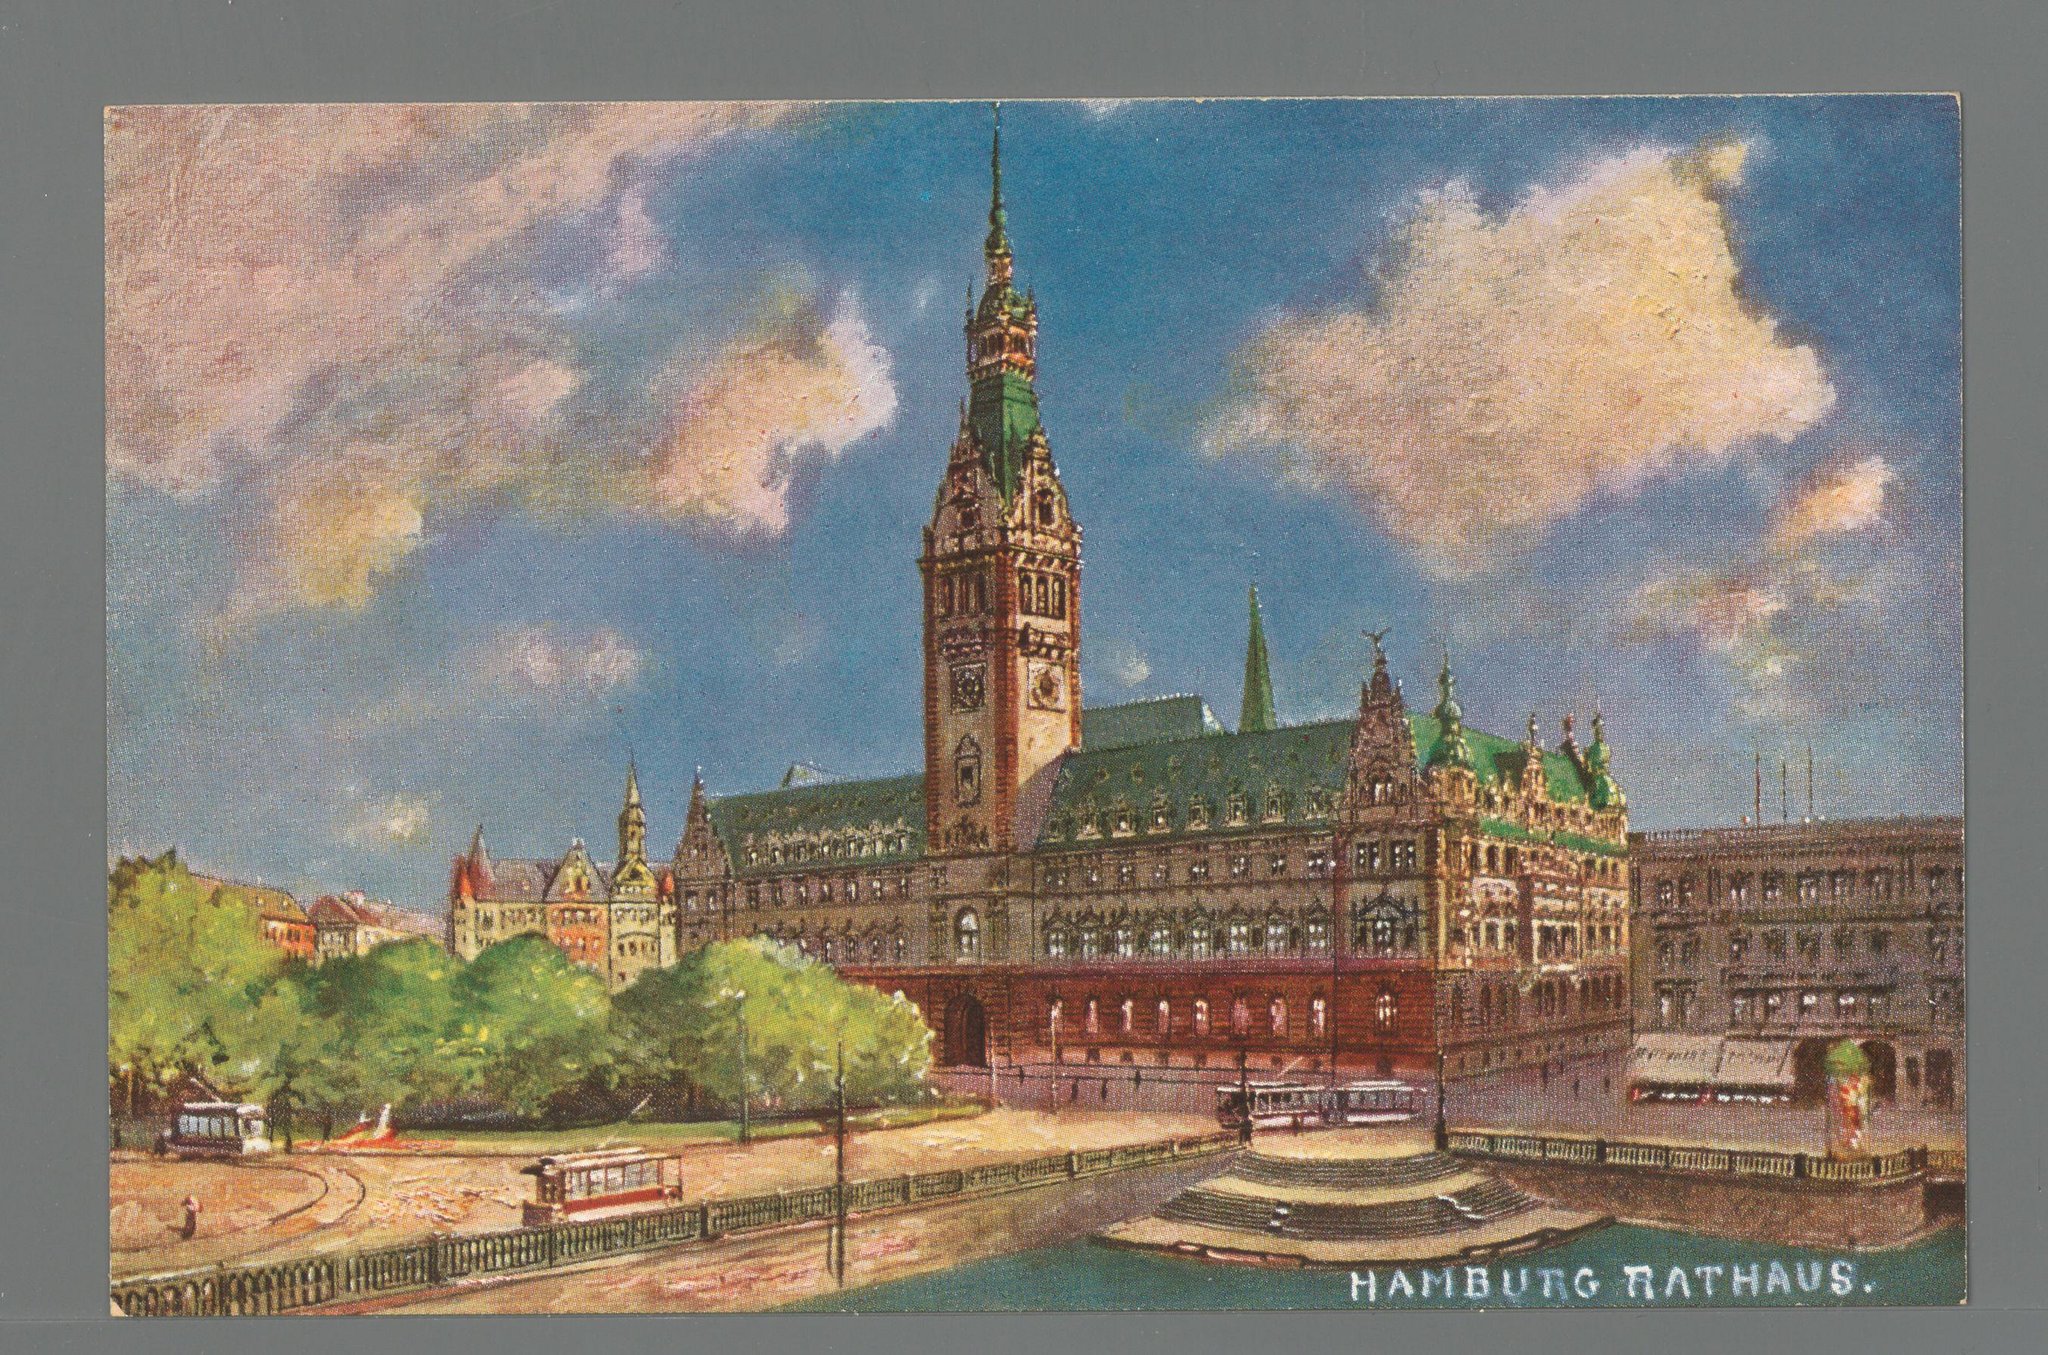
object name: reproduction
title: Hamburg. Rathaus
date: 1905-1930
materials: cardboard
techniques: color autotype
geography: nuremberg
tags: townhall